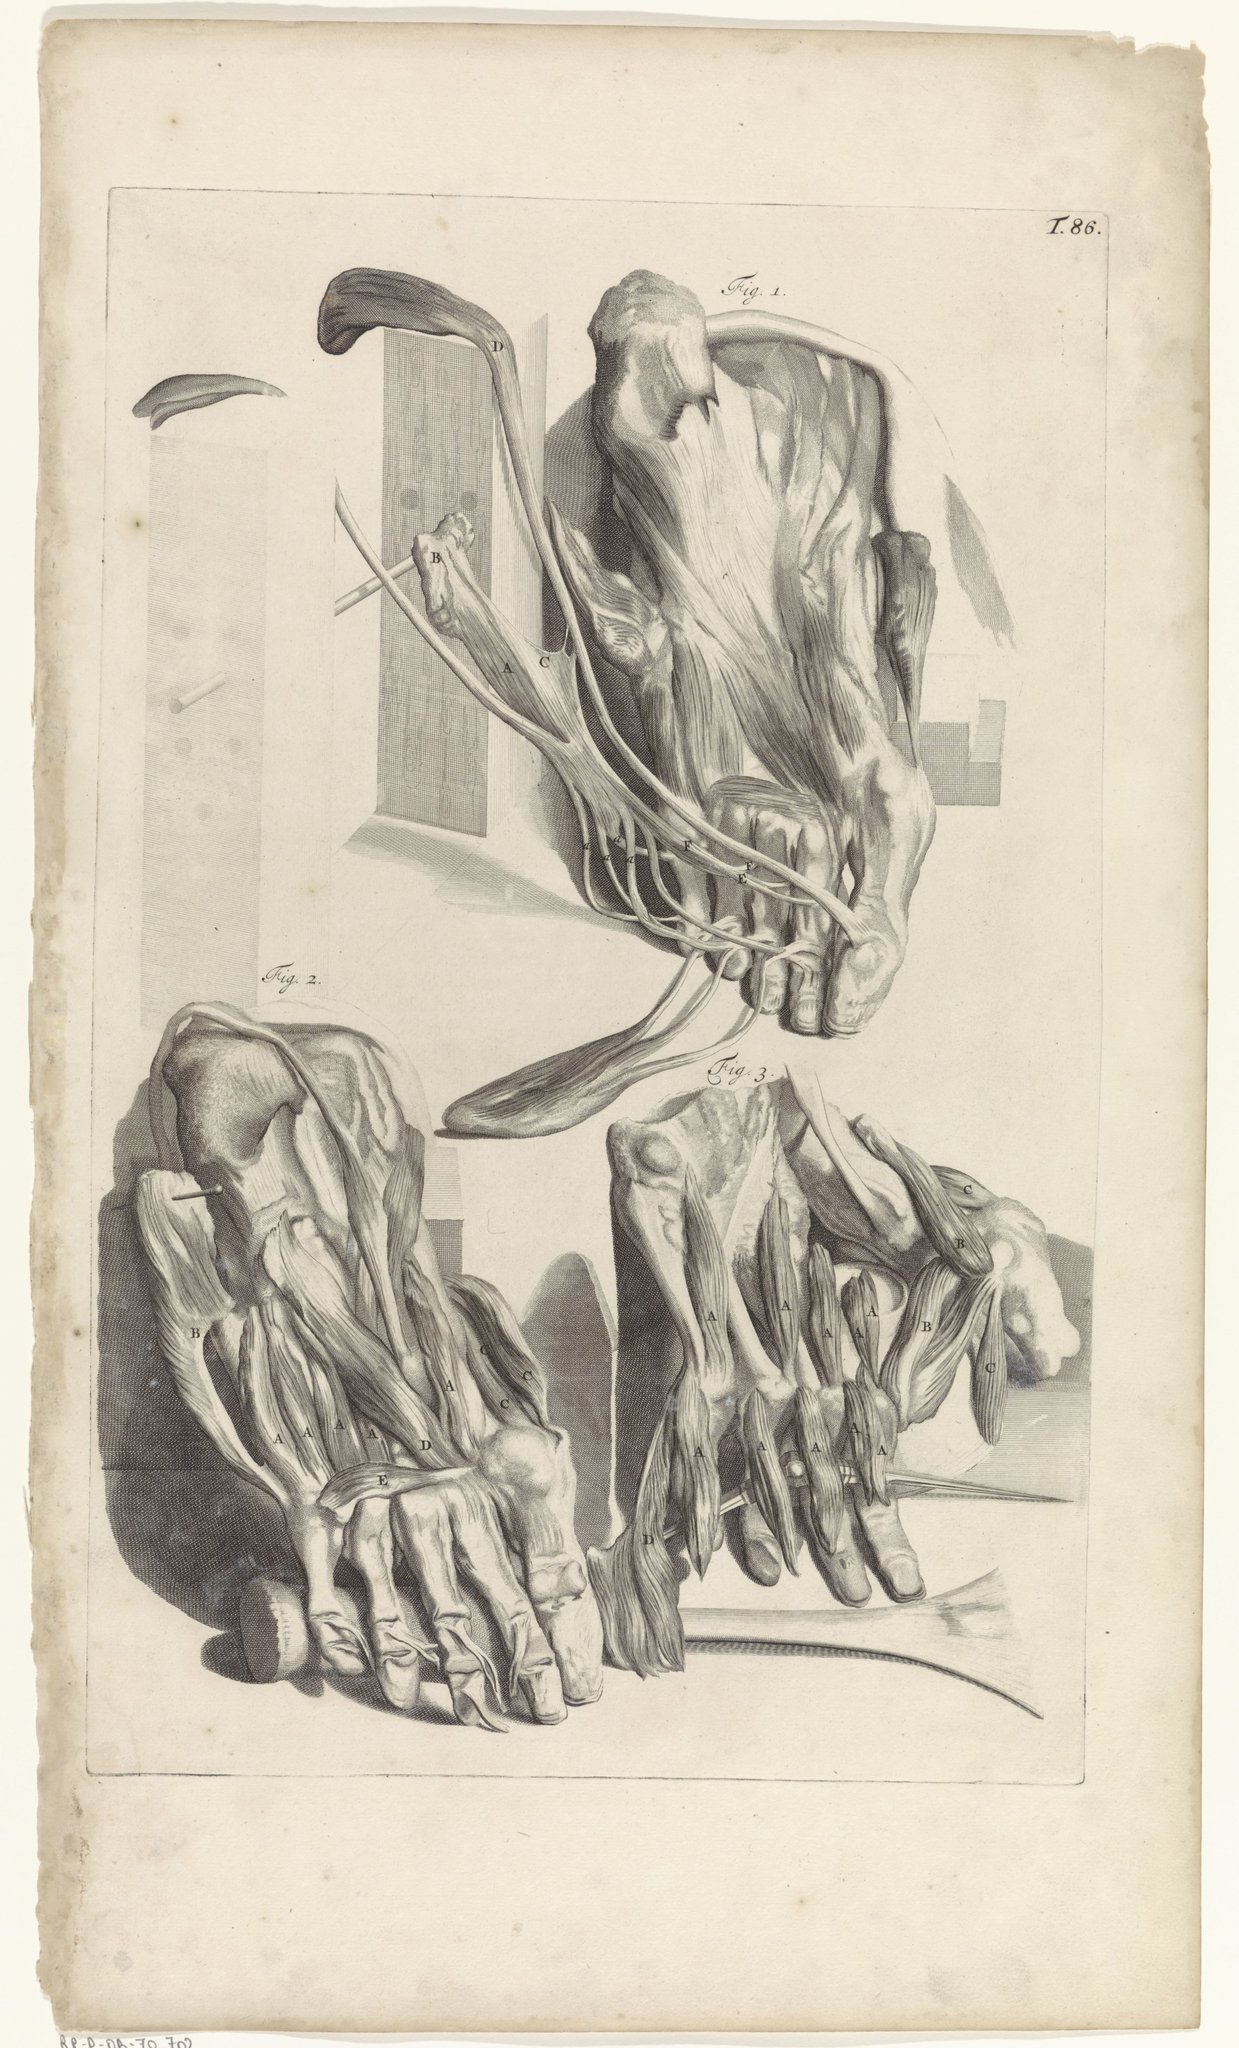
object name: book illustration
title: Anatomische studie van rechtervoet en de tenen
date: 1685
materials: paper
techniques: engraving, etching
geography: amsterdam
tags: tendons, sinews, muscles, foot, toes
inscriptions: collector's mark: Lugt 2228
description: Boekillustratie voor Bidloo, Godefridus. Anatomia humani corporis centum & quinque tabulis, per art. G. de Lairesse ad vivum delineatis, de monstrata, veterum recentiorumque inventis explicata plurimisque, hactenus non detectis, illustrata. Amsterdam: Weduwe Joannes van Someren, Hendrick Boom en erven Dirk Boom, 1685.